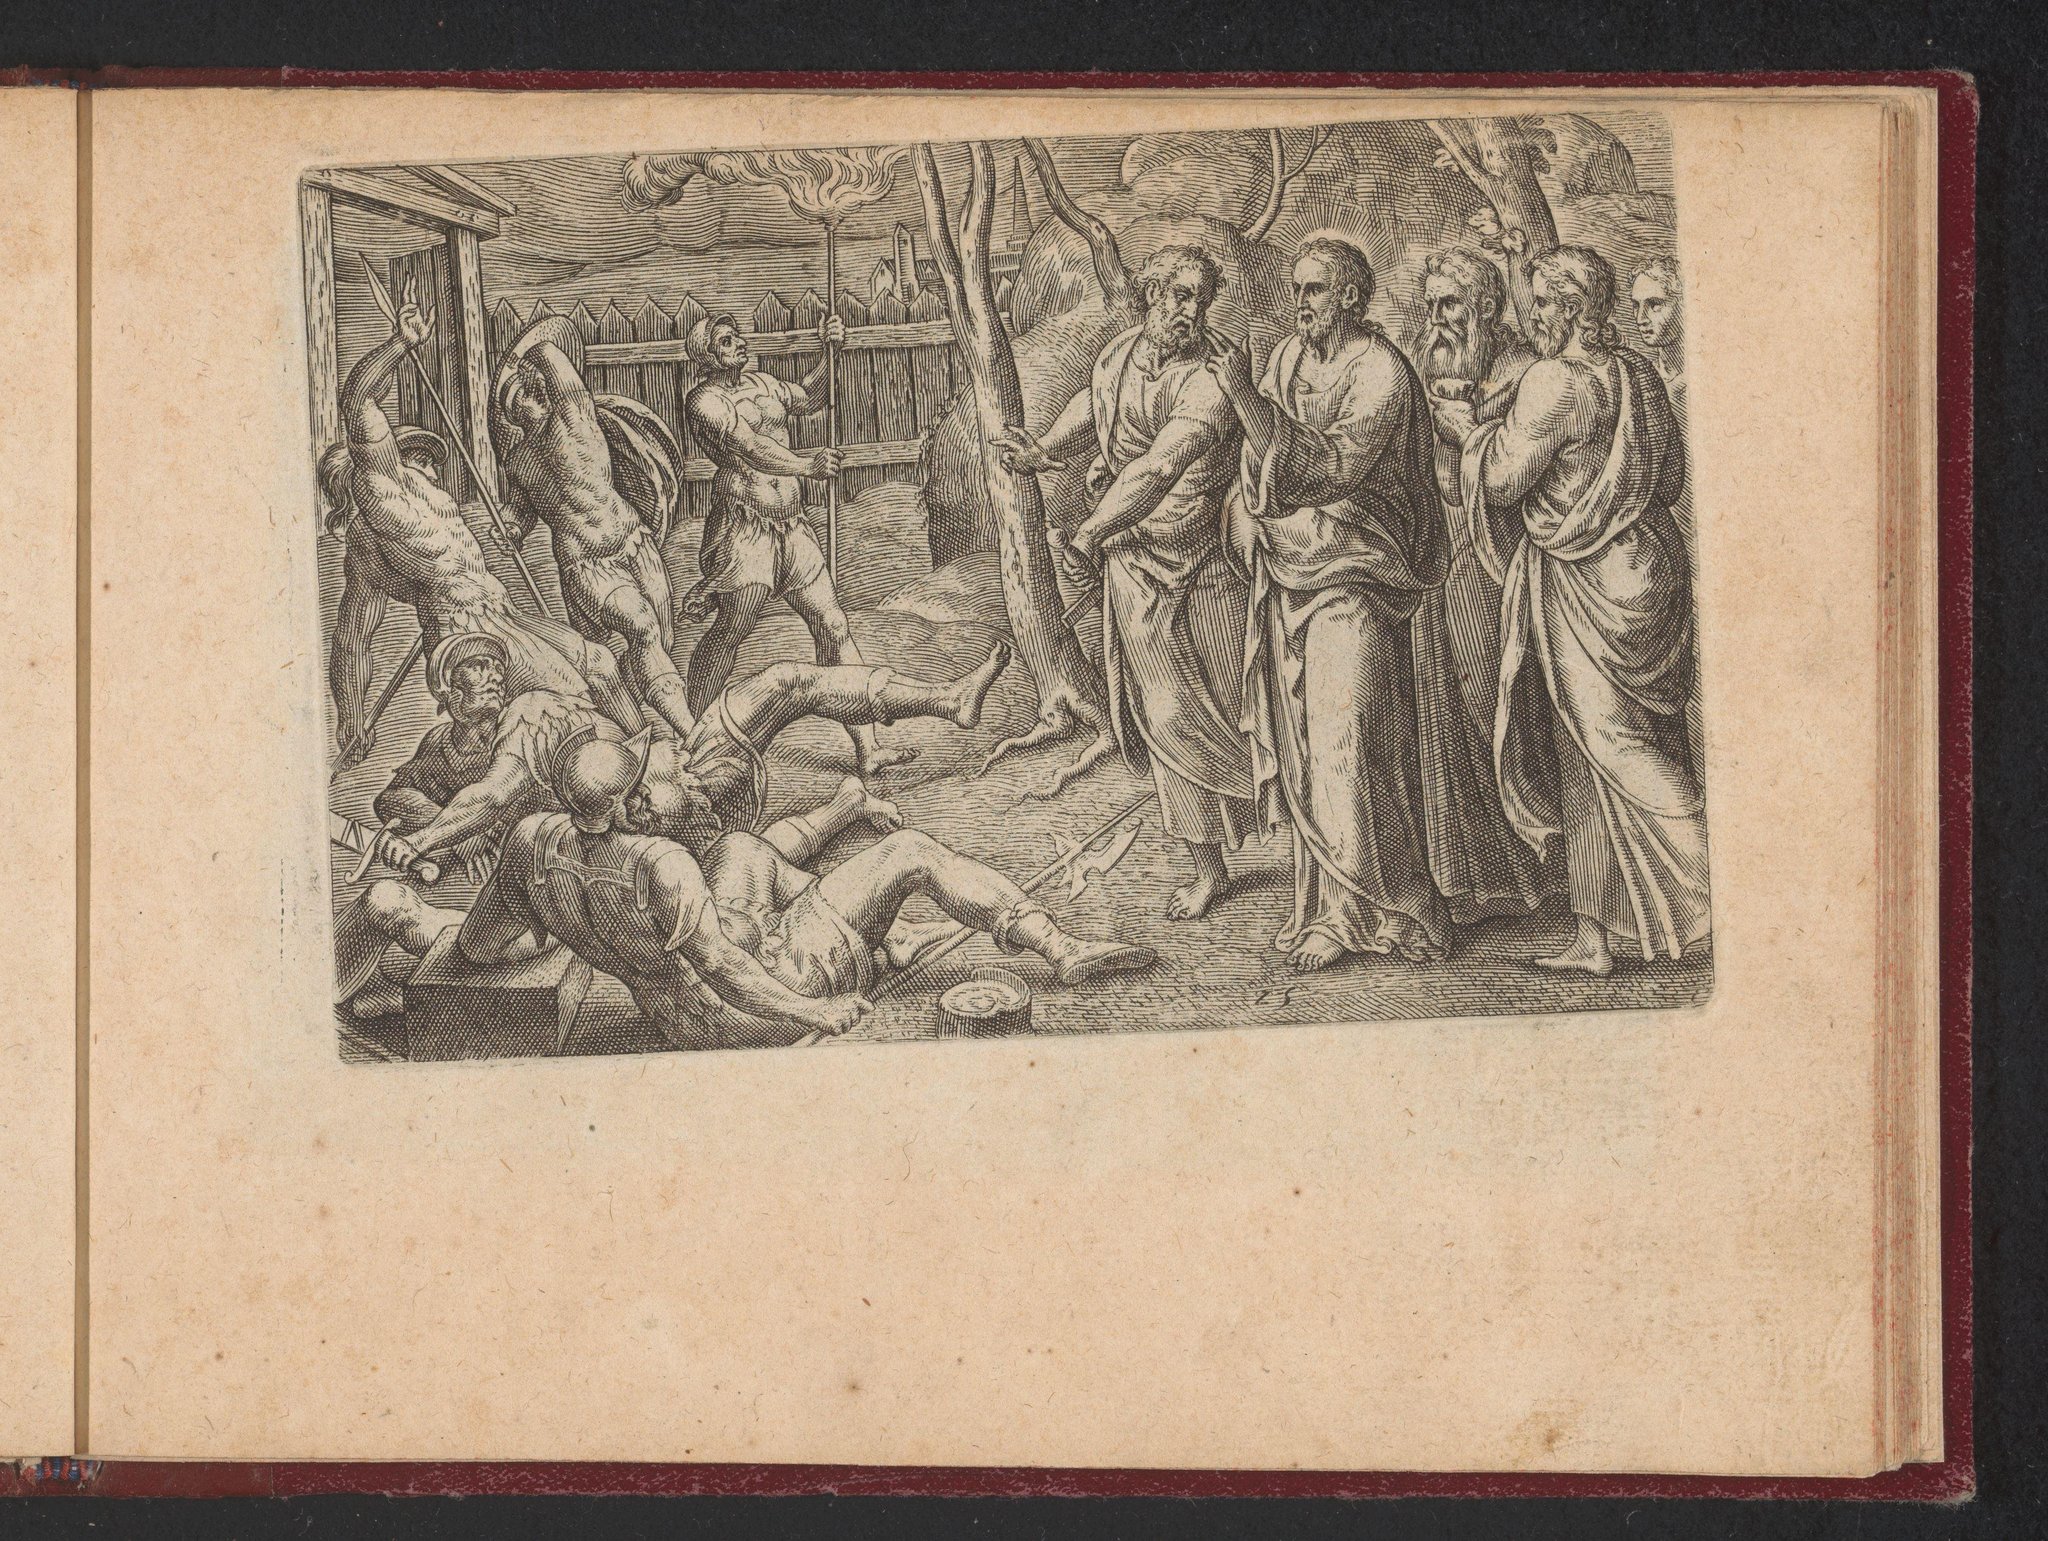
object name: print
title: Christi Iesu vitae admirabiliumque actionum speculum a Philippo Gallaeo apparatum Bened. Ariae Montani singuloribus distichis instructum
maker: philips galle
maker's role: print maker, publisher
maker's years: 1537-1612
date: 1573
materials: paper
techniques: engraving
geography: antwerp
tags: christ makes himself known; the soldiers fall to the ground ~ the kiss of judas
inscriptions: watermark: ‘gotische letter P’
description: Onderdeel van een album met een titelprent en een serie van 50 prenten betreffende het leven en de passie van Christus.